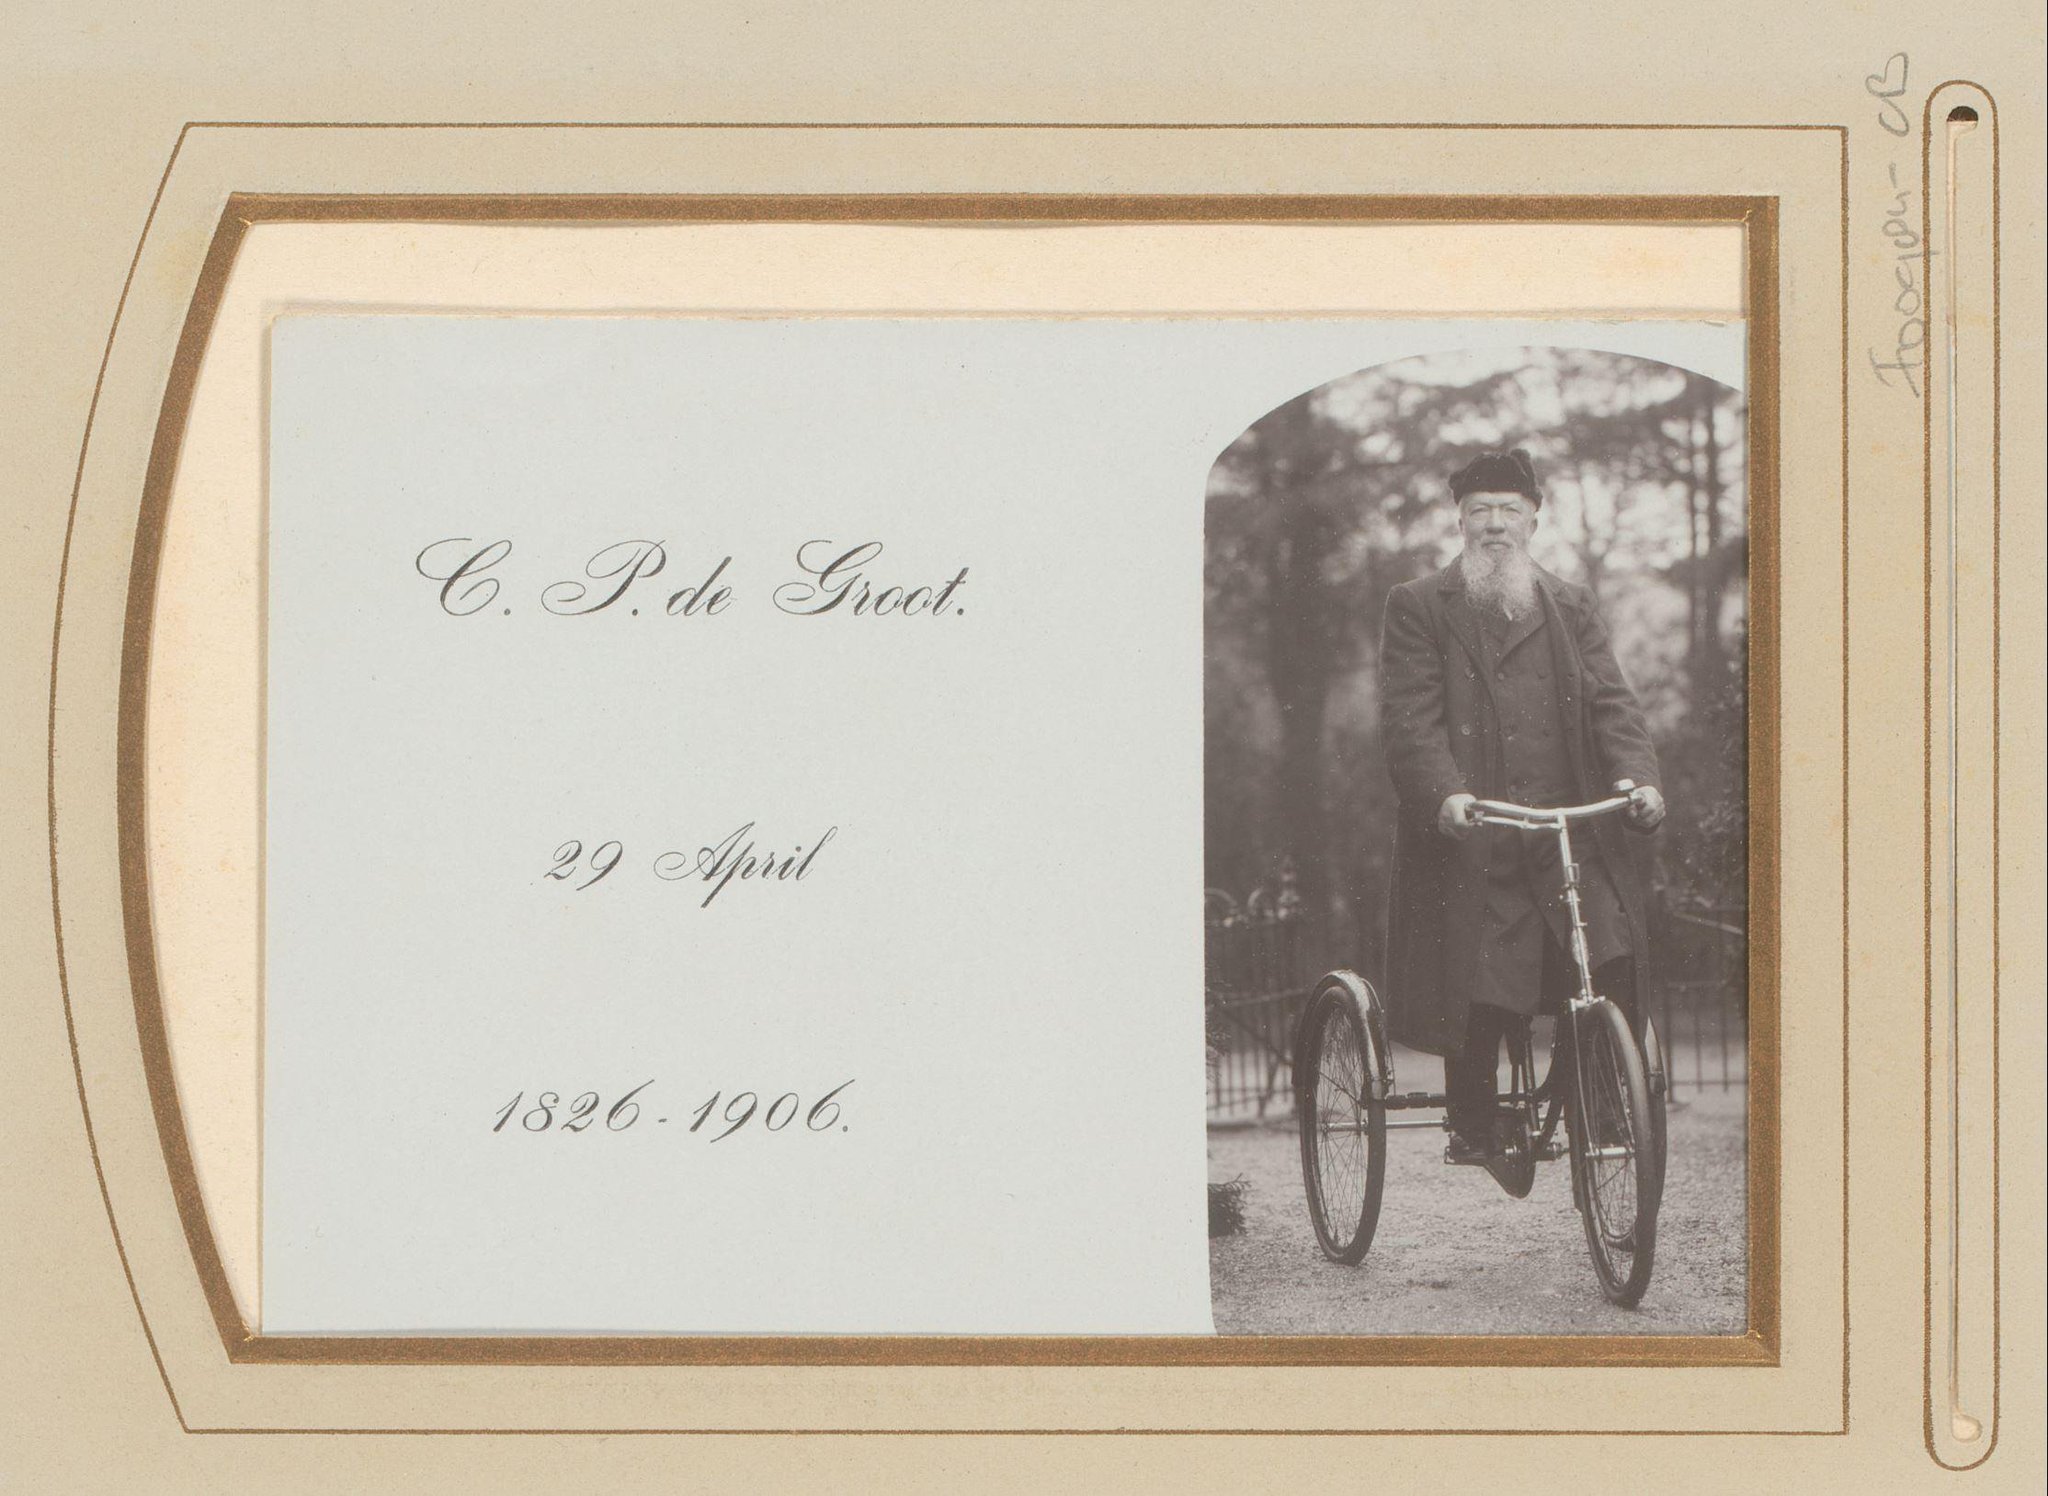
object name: photograph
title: Dankbetuiging met portret van C.P. de Groot op een driewieler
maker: Anonymous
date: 1900-1906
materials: cardboard, photographic support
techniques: collodion silver print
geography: netherlands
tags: mourning card, death notice, obituary, tricycle, historical persons